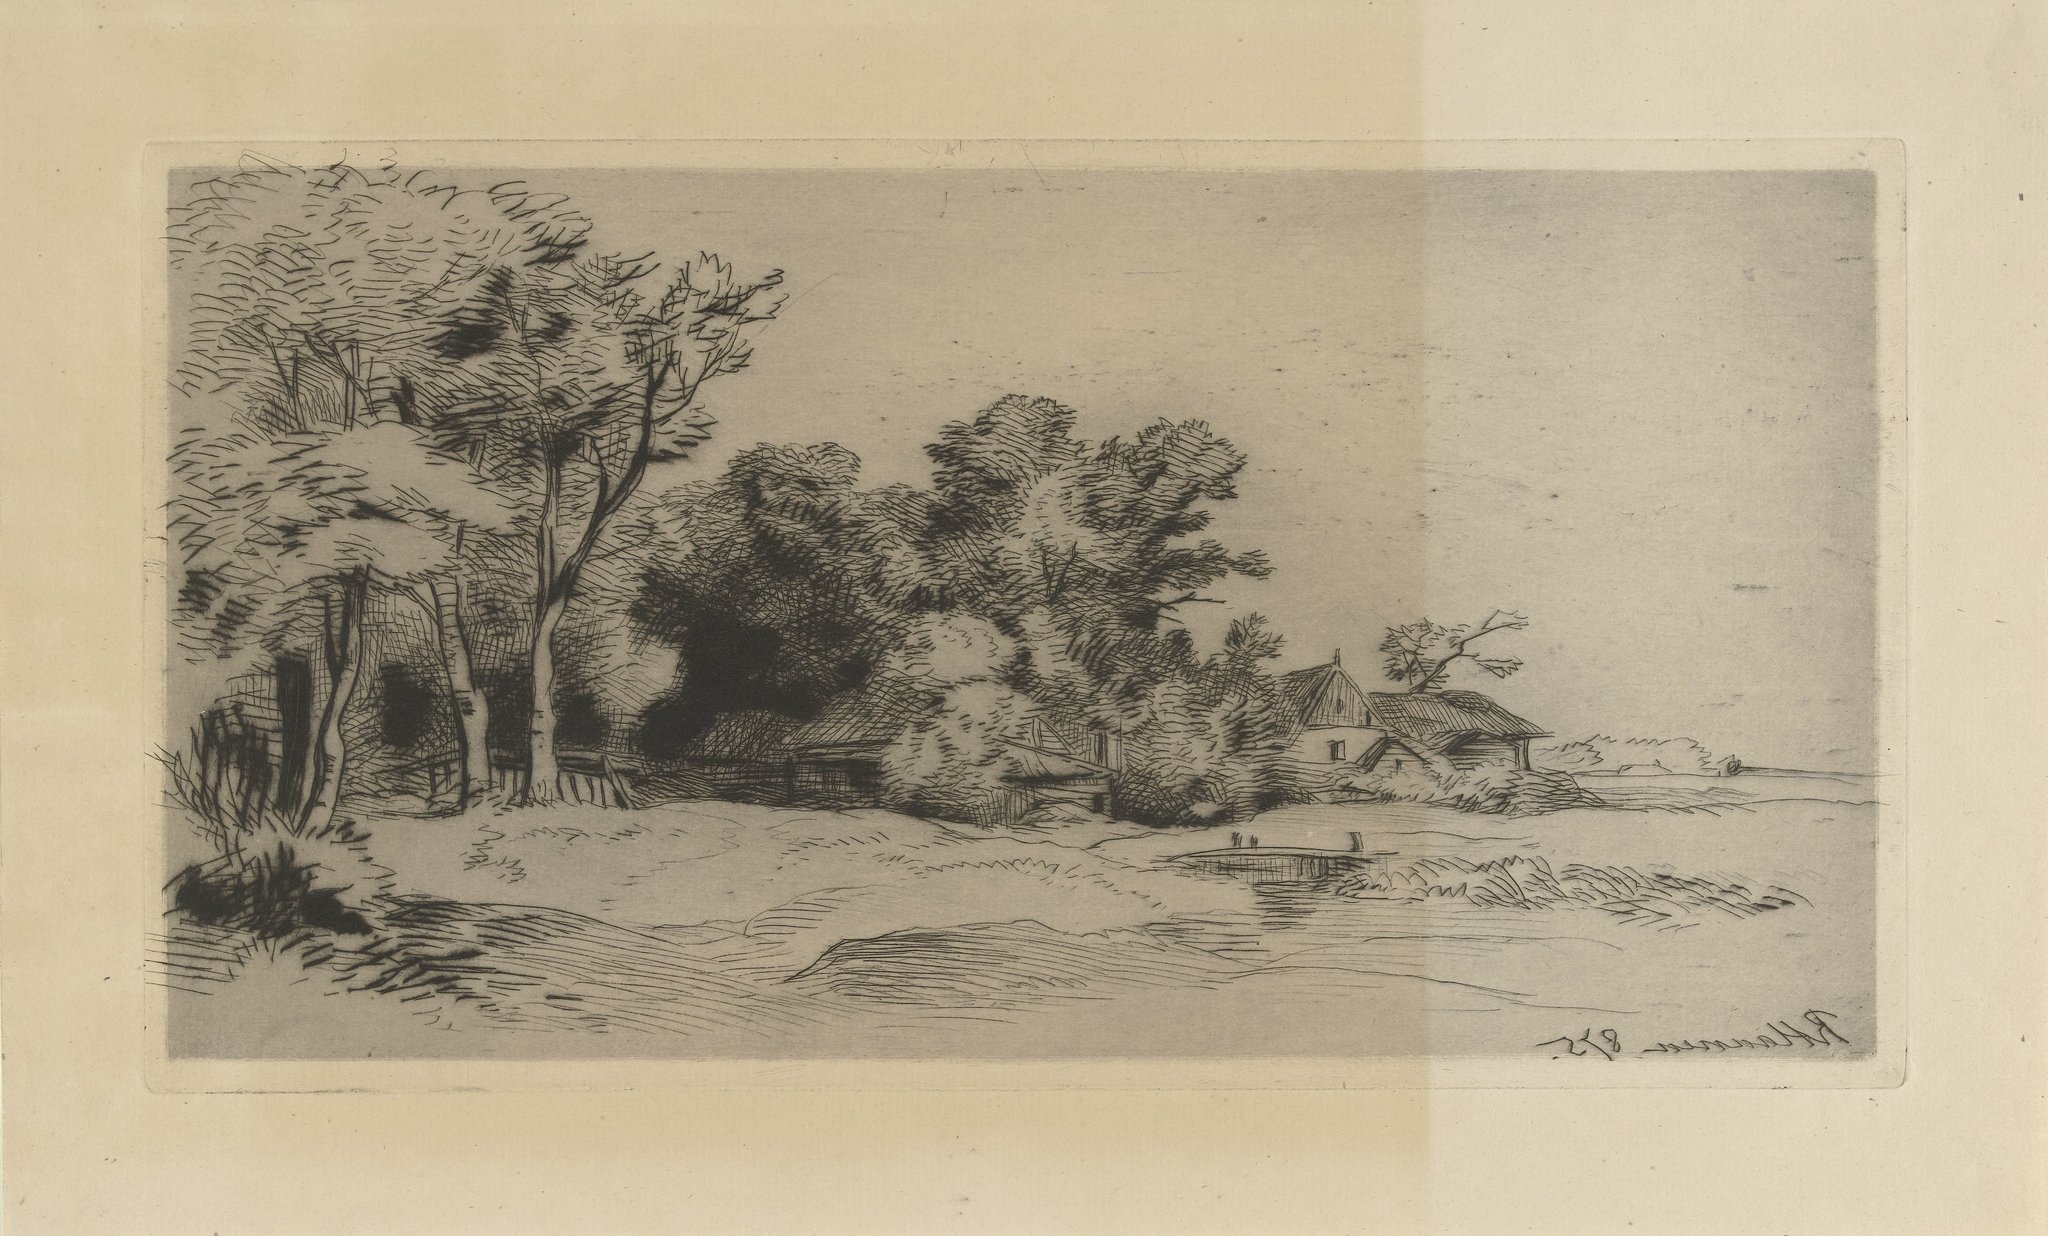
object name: print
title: Landschap met boerderij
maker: remigius adrianus haanen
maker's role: draughtsman, painter, print maker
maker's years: 1812-1894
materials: paper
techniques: drypoint, etching, intaglio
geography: austria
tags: farm or solitary house in landscape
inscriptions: collector's mark: Lugt 2228